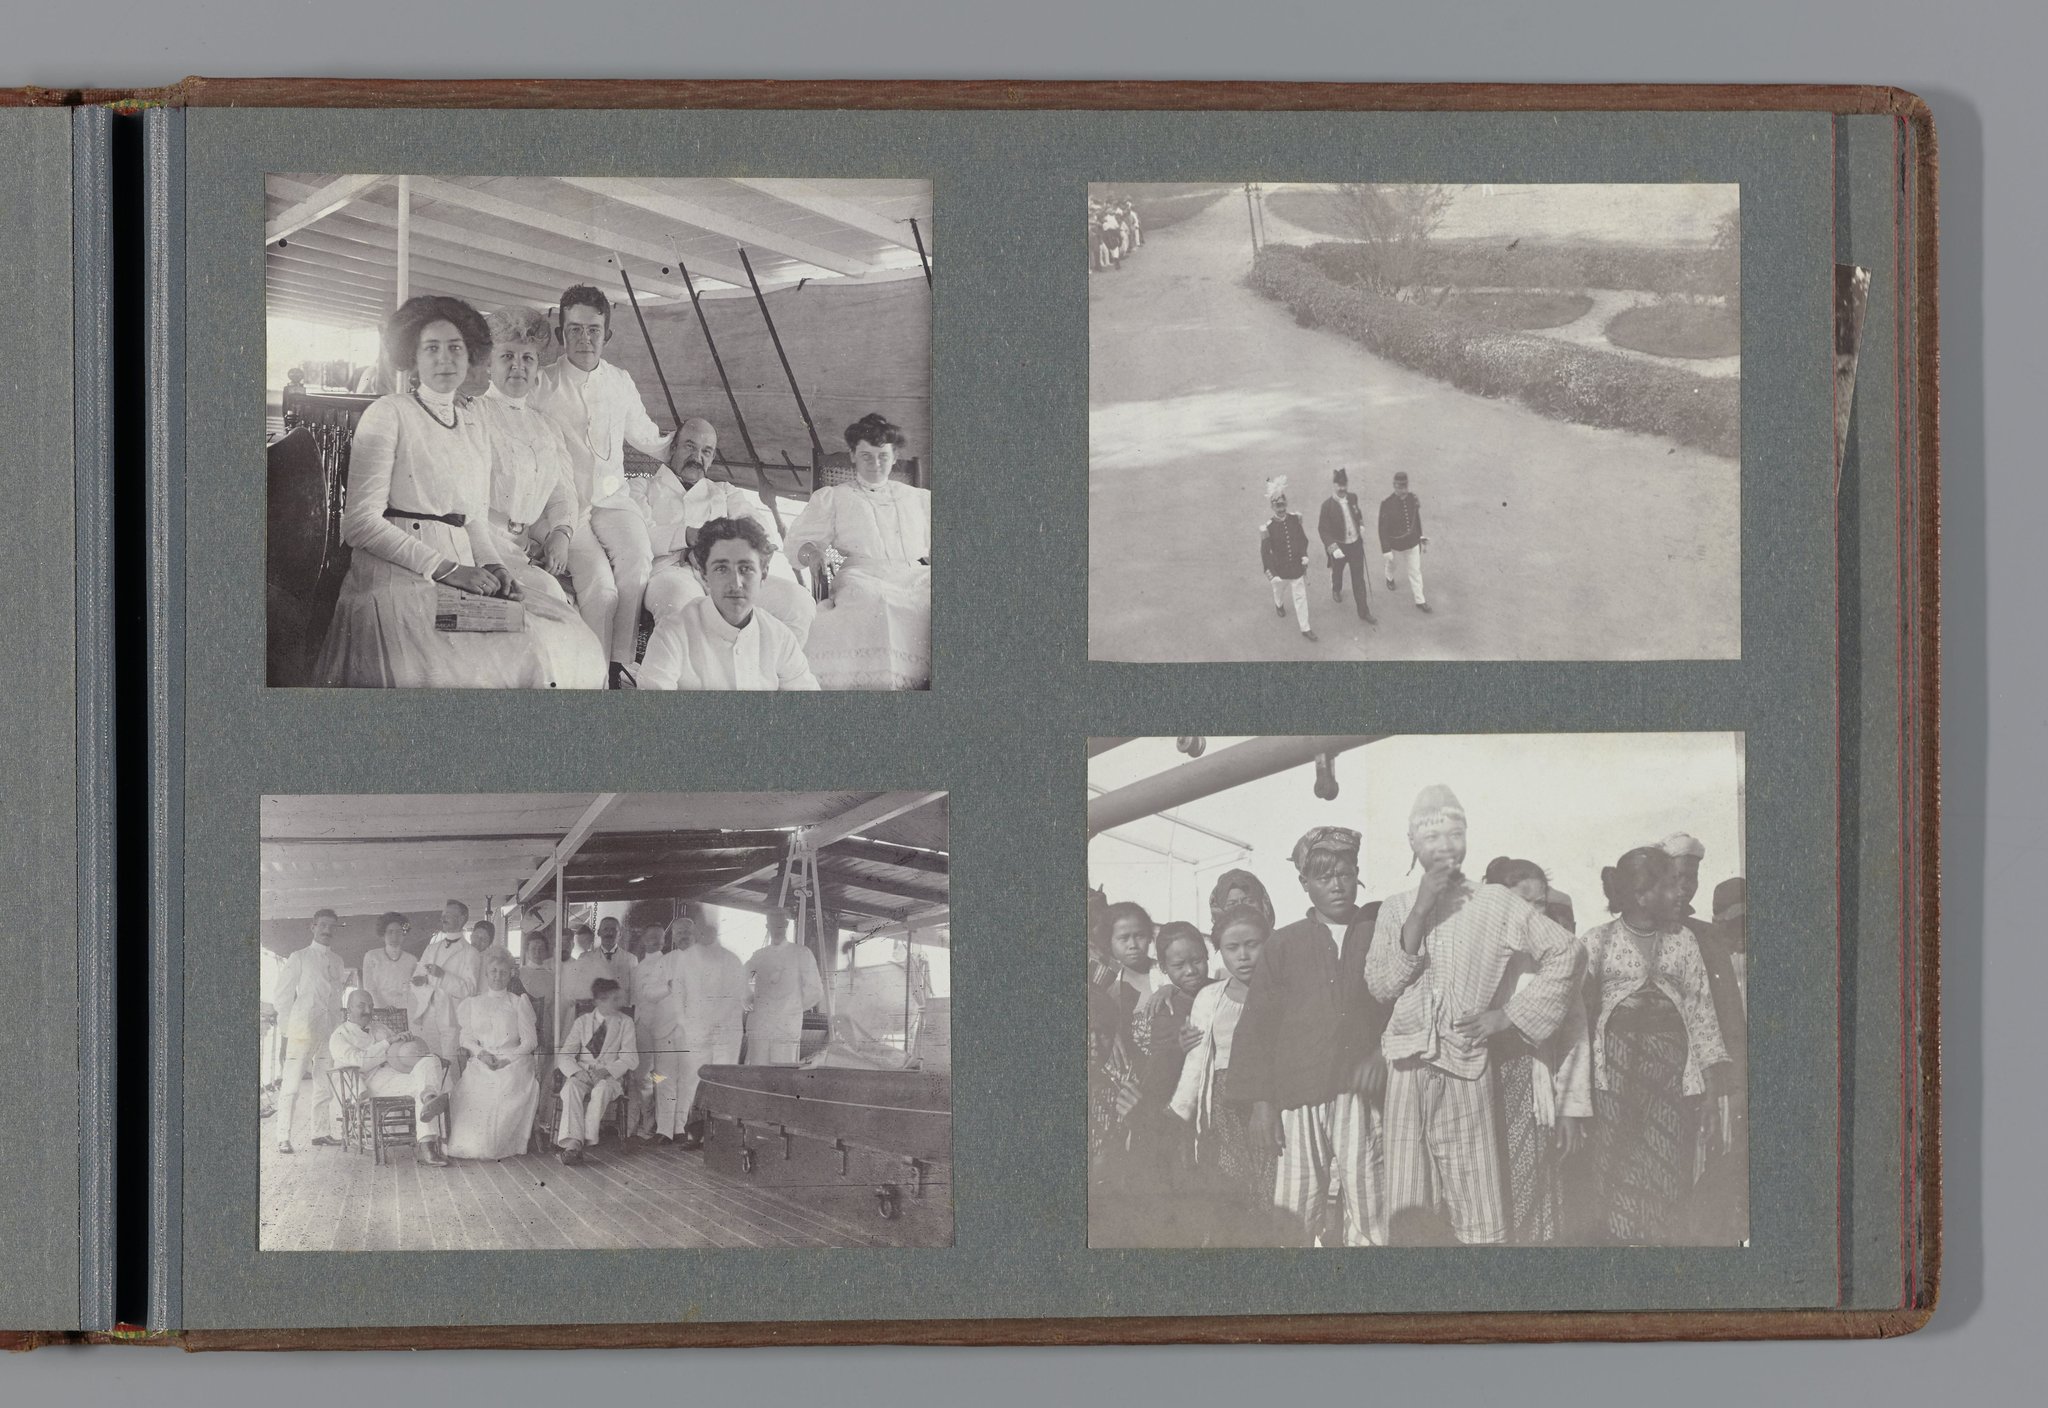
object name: photograph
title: Gezelschap van vijftien mensen aan boord van een schip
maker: Anonymous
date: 1905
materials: cardboard, paper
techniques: photography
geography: paramaribo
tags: suriname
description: Gezelschap van vijftien mensen aan boord van een schip. Onderdeel van fotoalbum 'Suriname'.